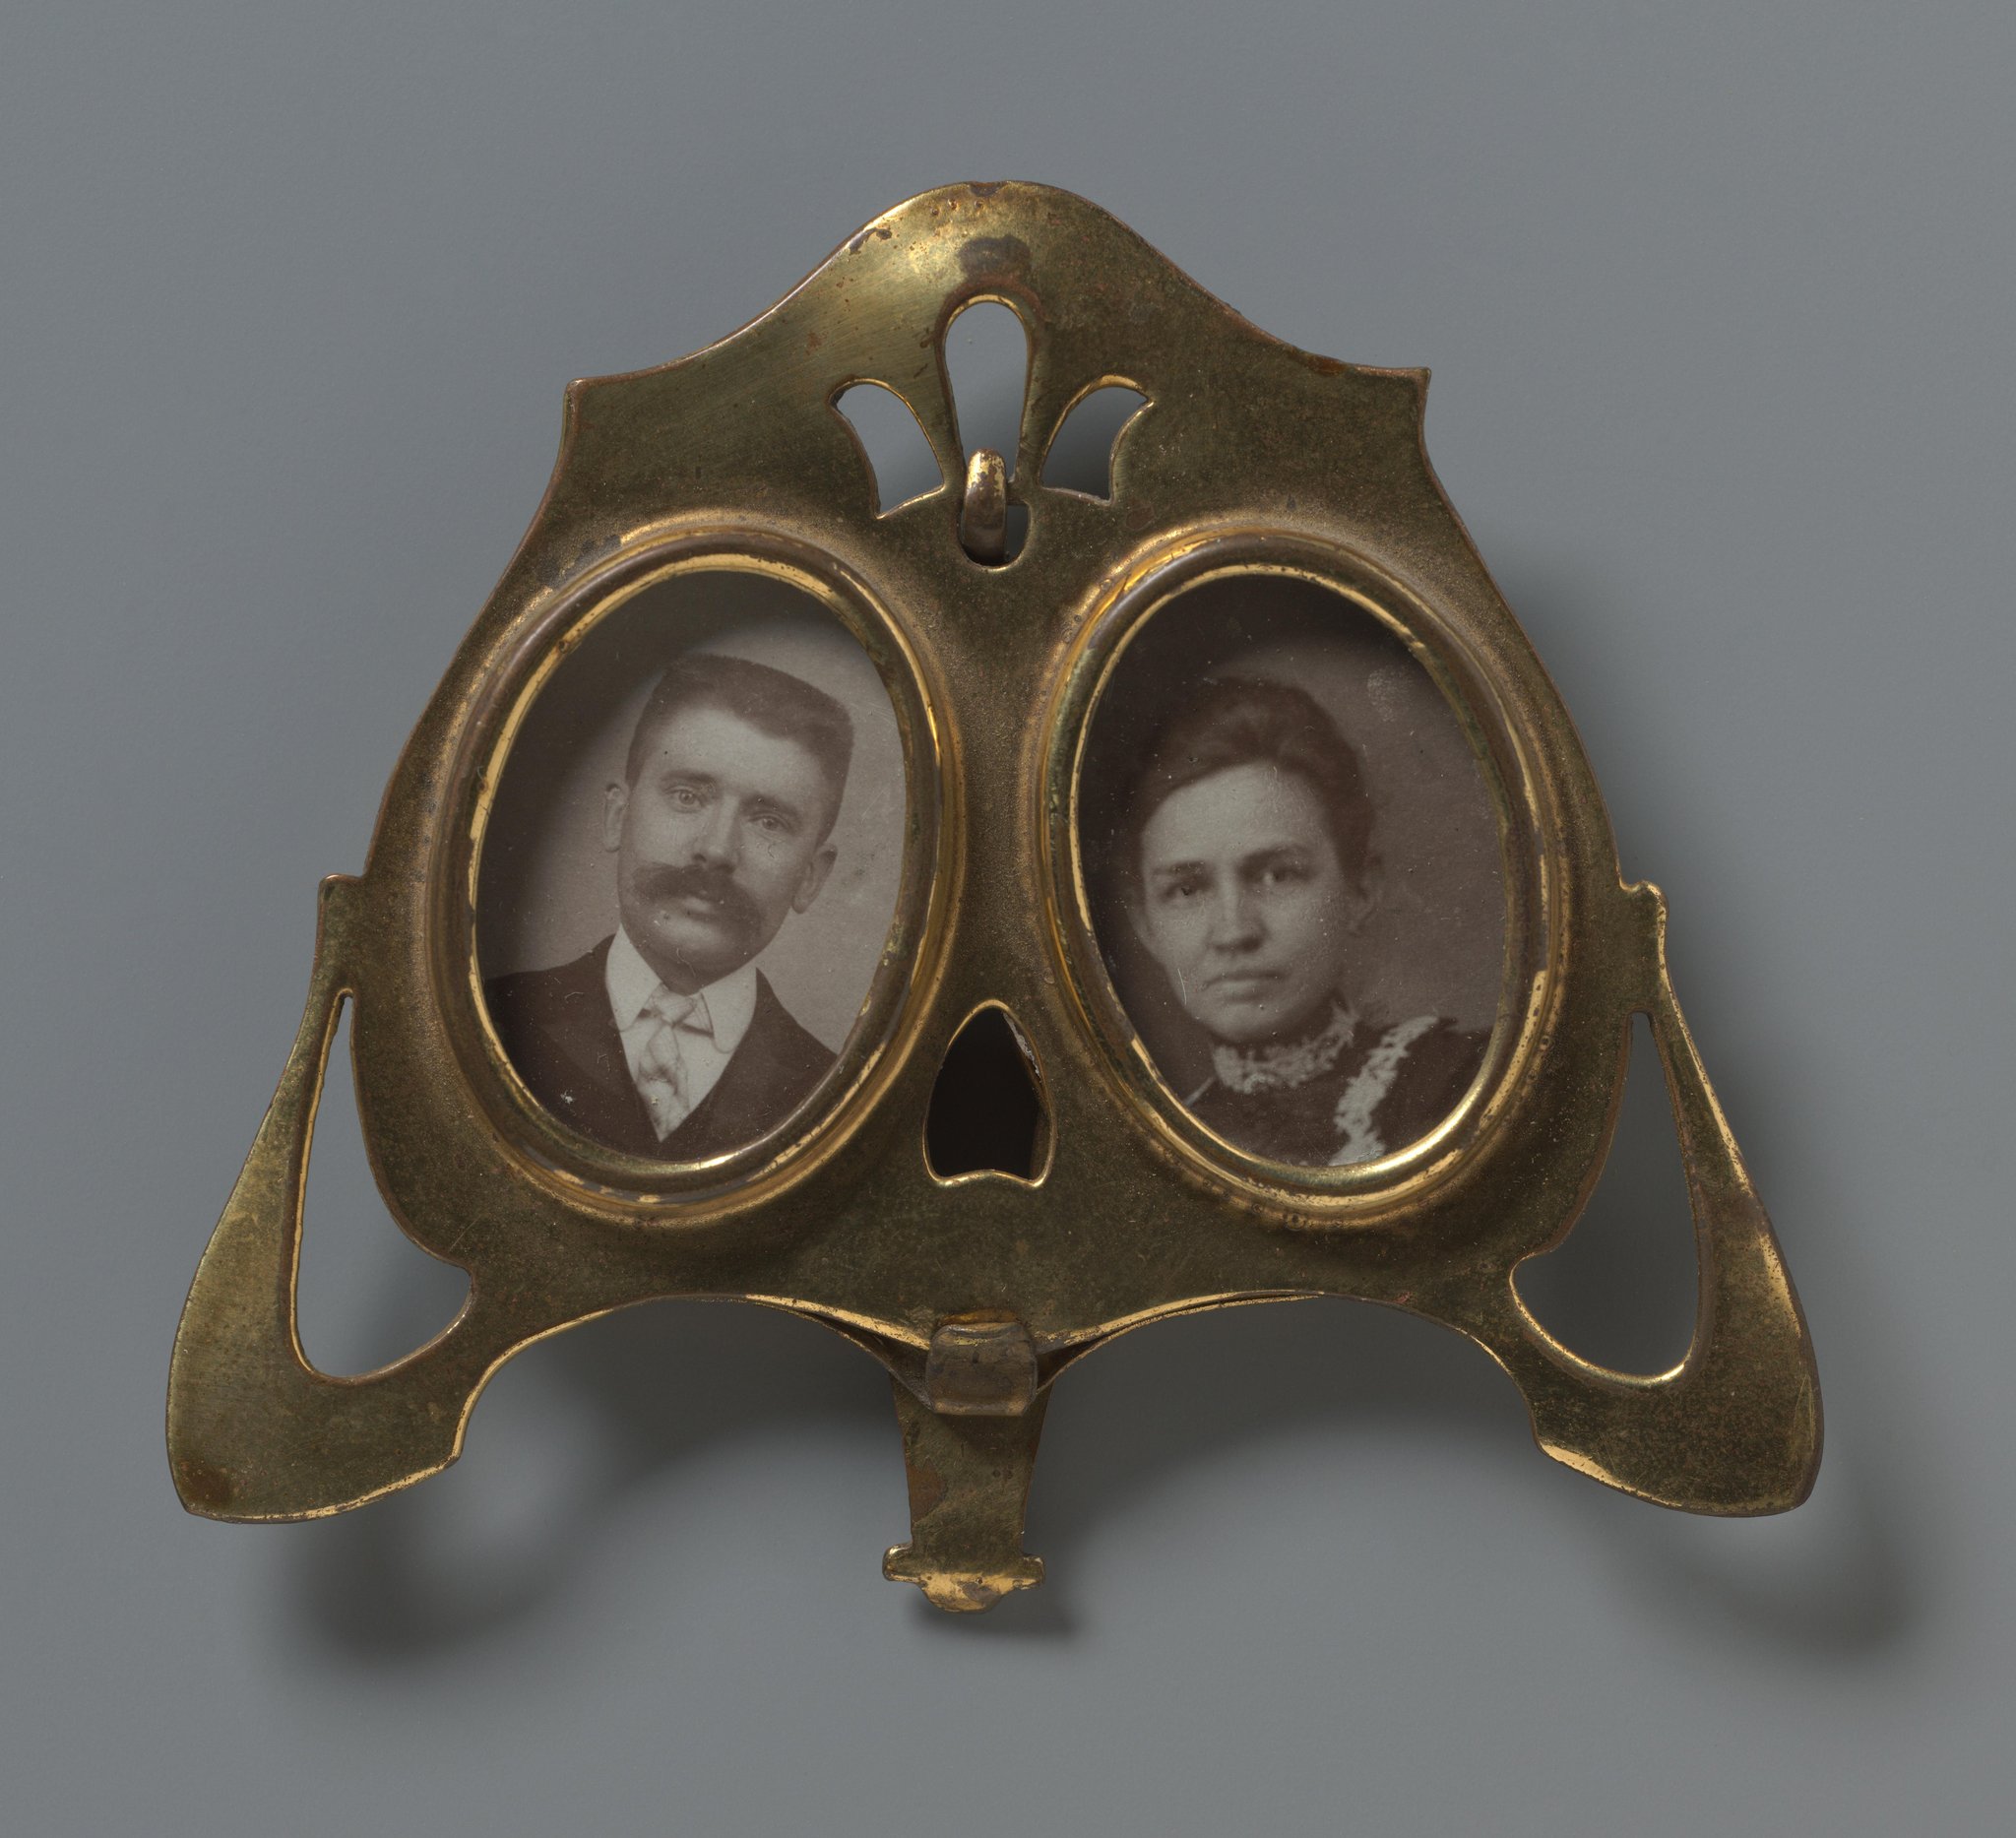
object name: frame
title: Twee portretten van een onbekend echtpaar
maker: Anonymous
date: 1890-1910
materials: paper, glass, metal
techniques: daylight paper print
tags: anonymous historical persons portrayed in a double portrait